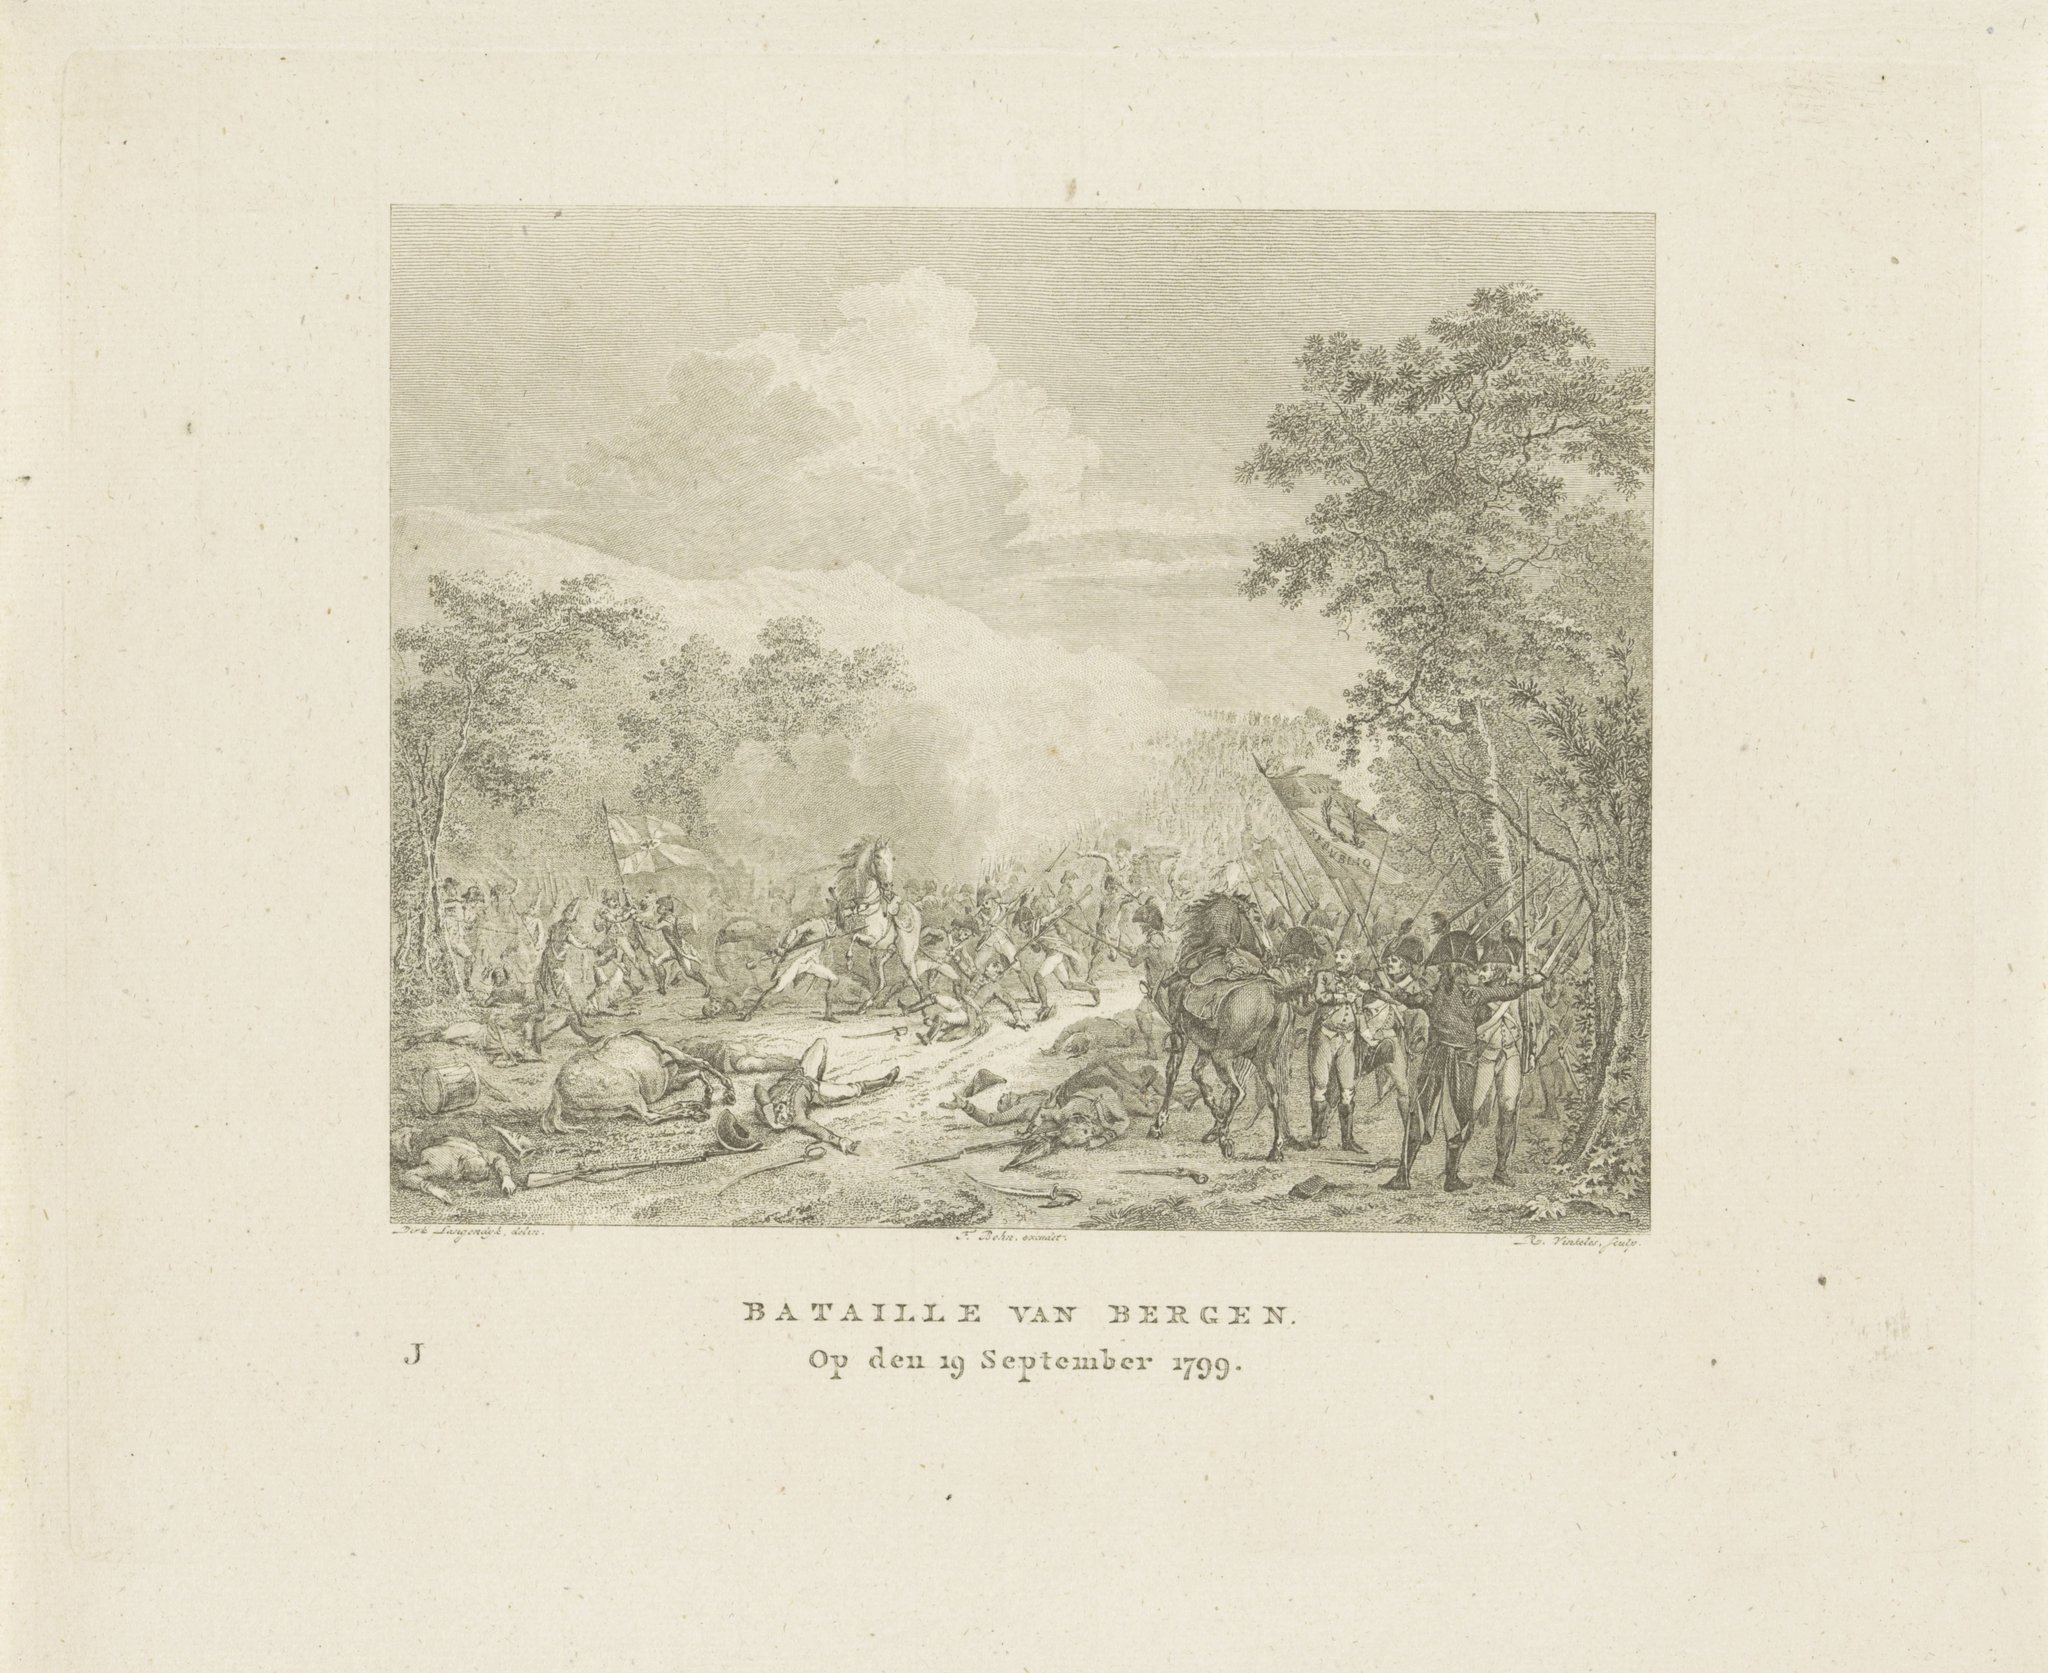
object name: print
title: Bataille van Bergen. Op den 19 September 1799.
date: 1800-1802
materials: paper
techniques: engraving, etching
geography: haarlem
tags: battle (+ land forces)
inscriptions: collector's mark: Lugt 2228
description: Gebruikt als illustratie in: L.C. Vonk. Geschiedenis der landing van het Engelsch-Russisch leger in Noord-Holland; alsmede der krijgsbedrijven en politieke gebeurtenissen, zoo aldaar, als in Vriesland en Gelderland, in den jare 1799. Haarlem: François Bohn, 2 dln, 1801-1802.